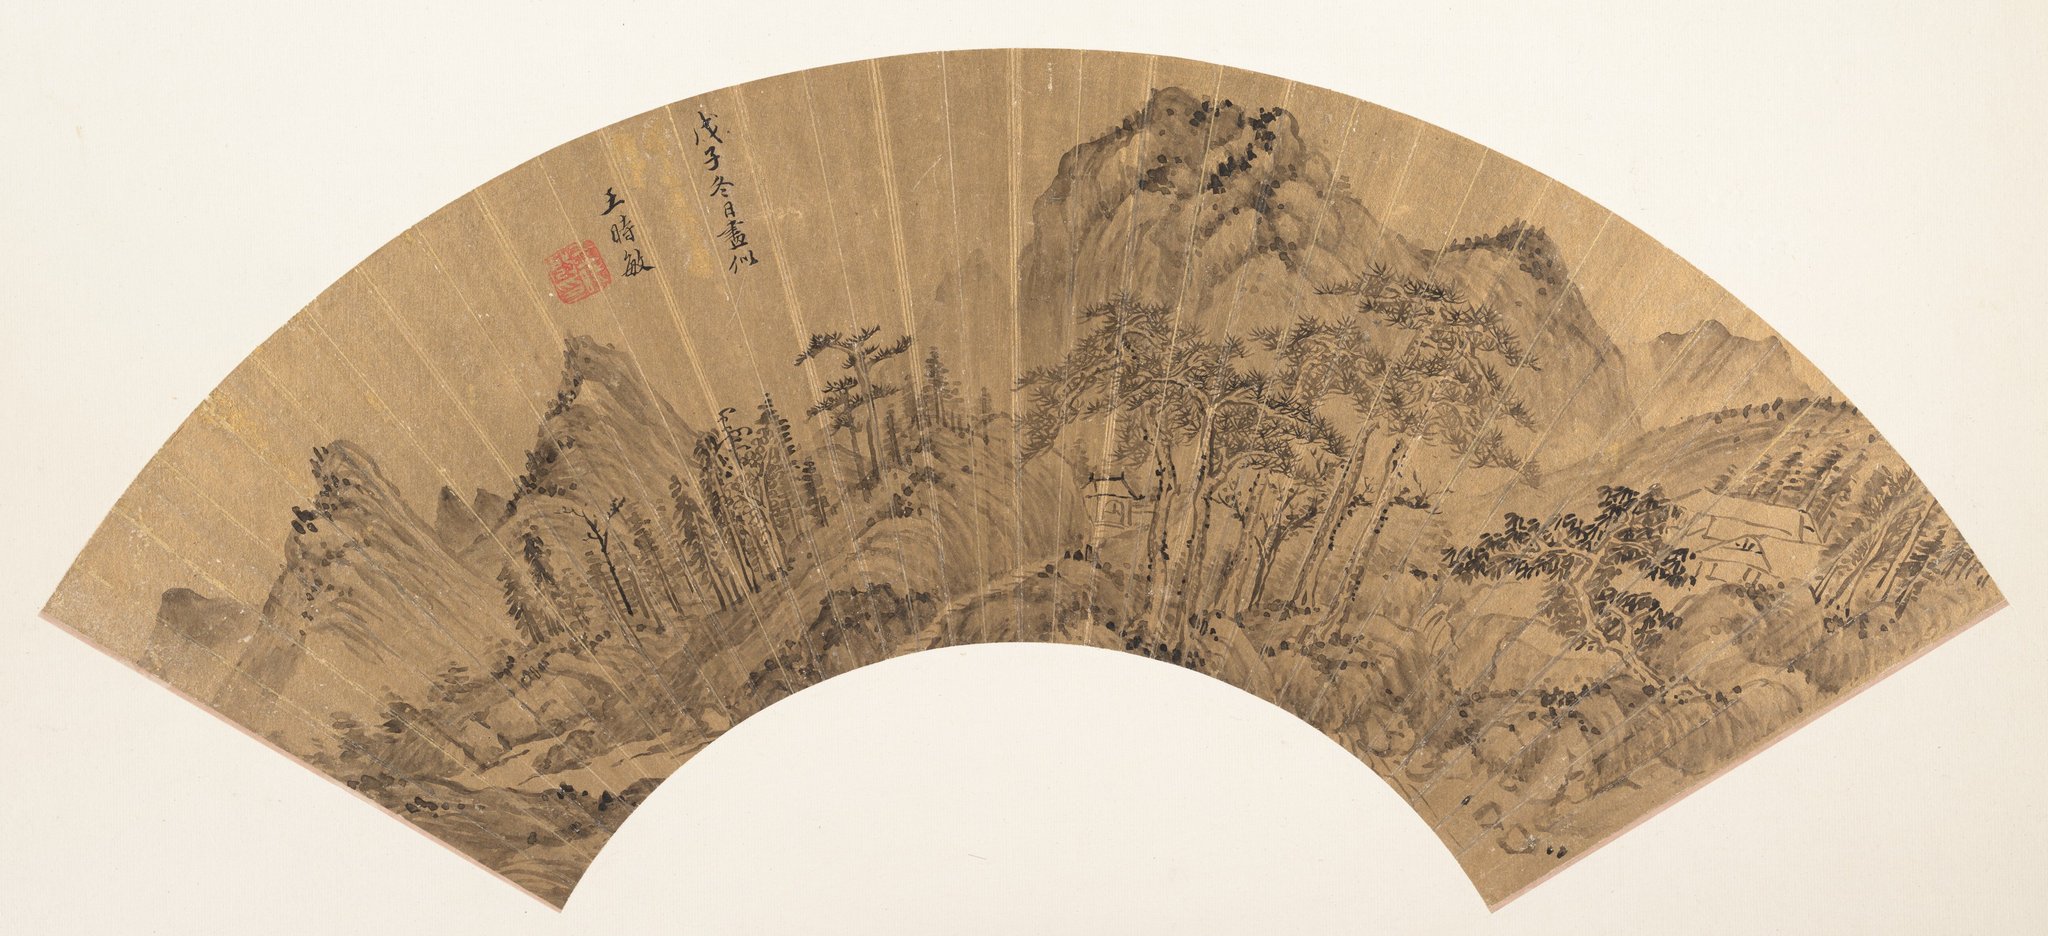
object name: folding fan mounted a an album leaf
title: Landscape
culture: chinese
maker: unidentified artist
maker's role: artist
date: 1701-1800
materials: gold, ink, paper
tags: mountains,landscapes